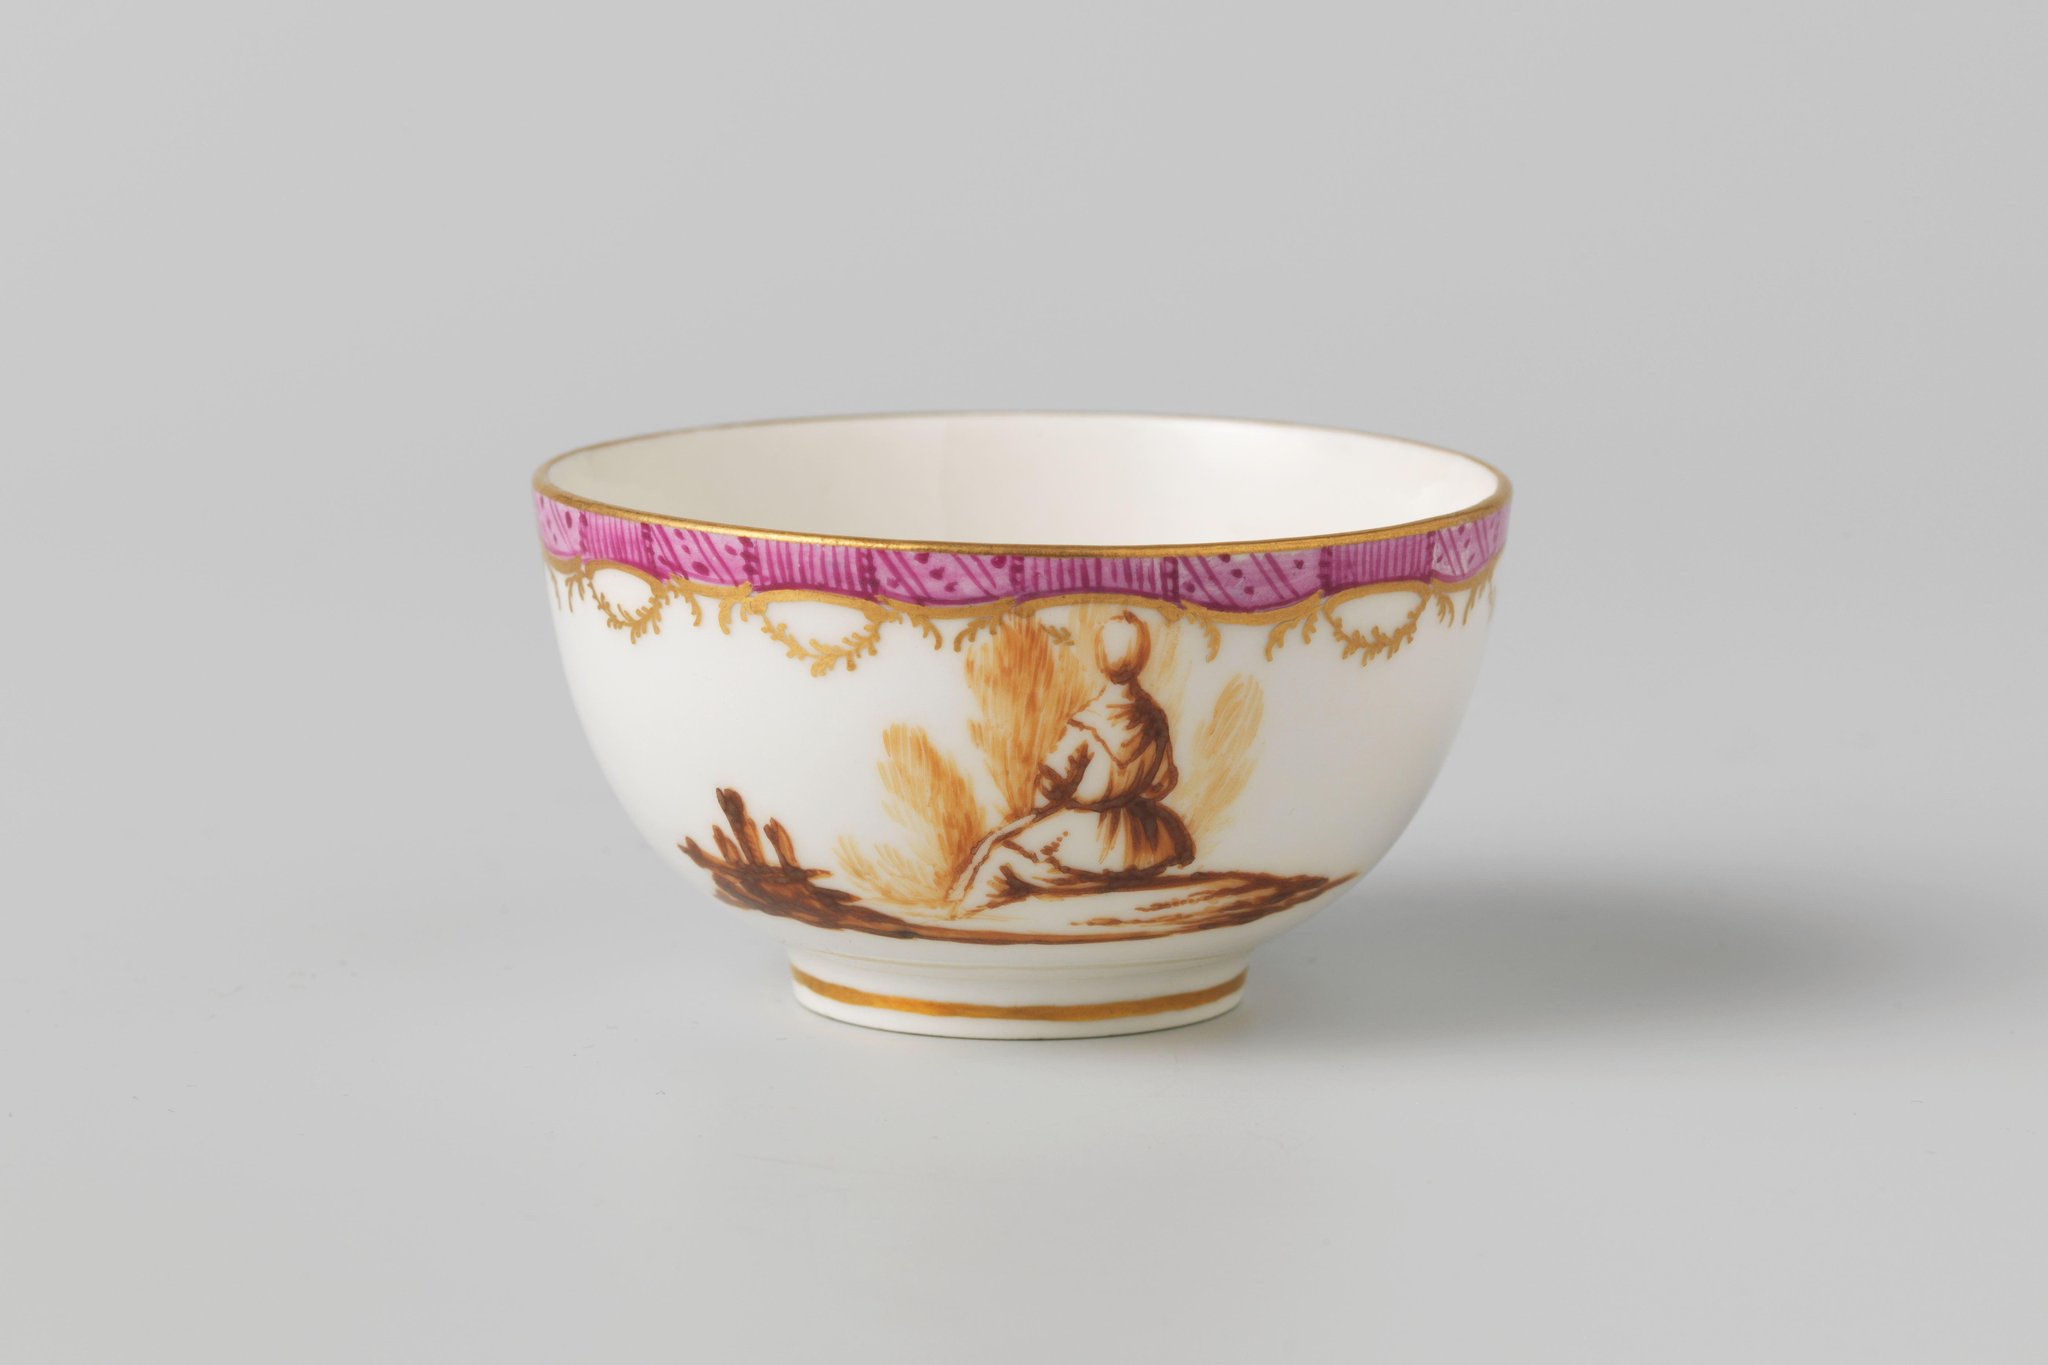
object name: tea cup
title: Theekop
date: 1774-1778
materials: porcelain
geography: loosdrecht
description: Theekop zonder oor van porselein. Beschilderd in sepia met figuren in een landschap. Langs de randen een lila fries tussen gouden biezen.